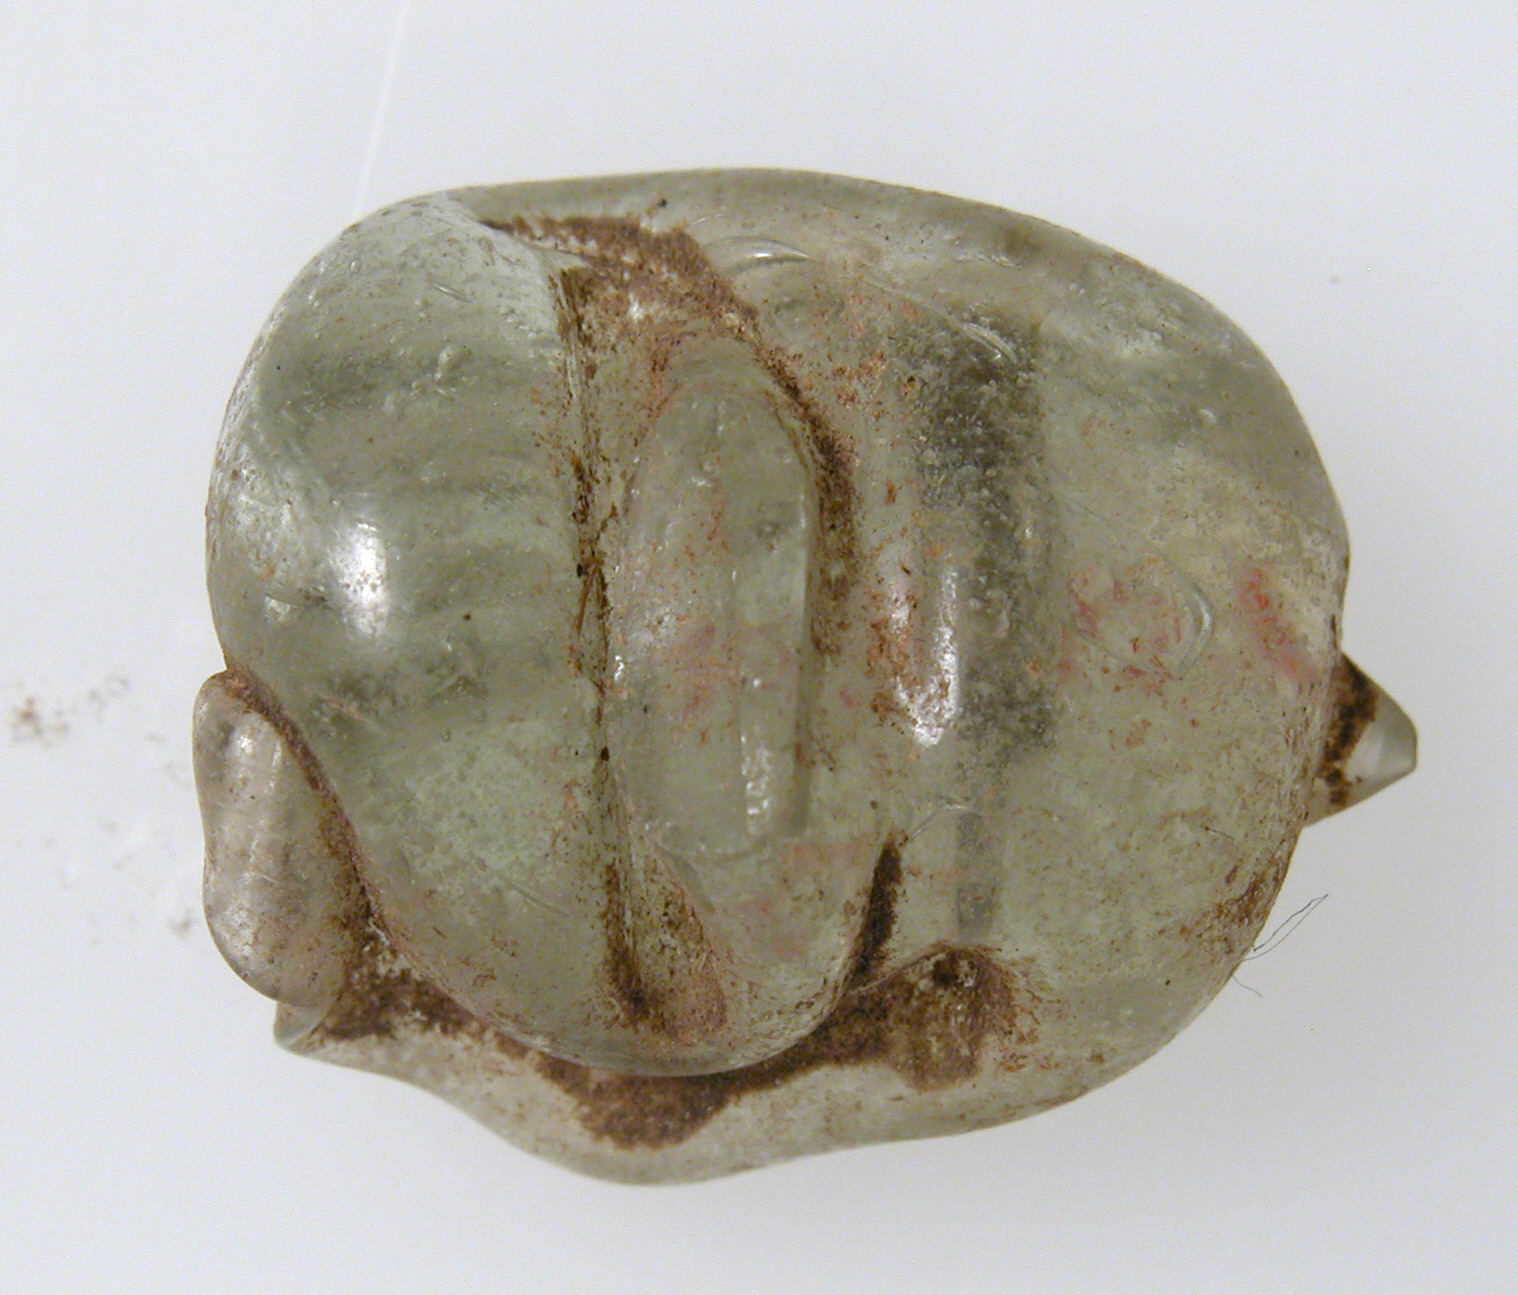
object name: fragment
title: Glass Fragment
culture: coptic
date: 301-433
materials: glass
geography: egypt